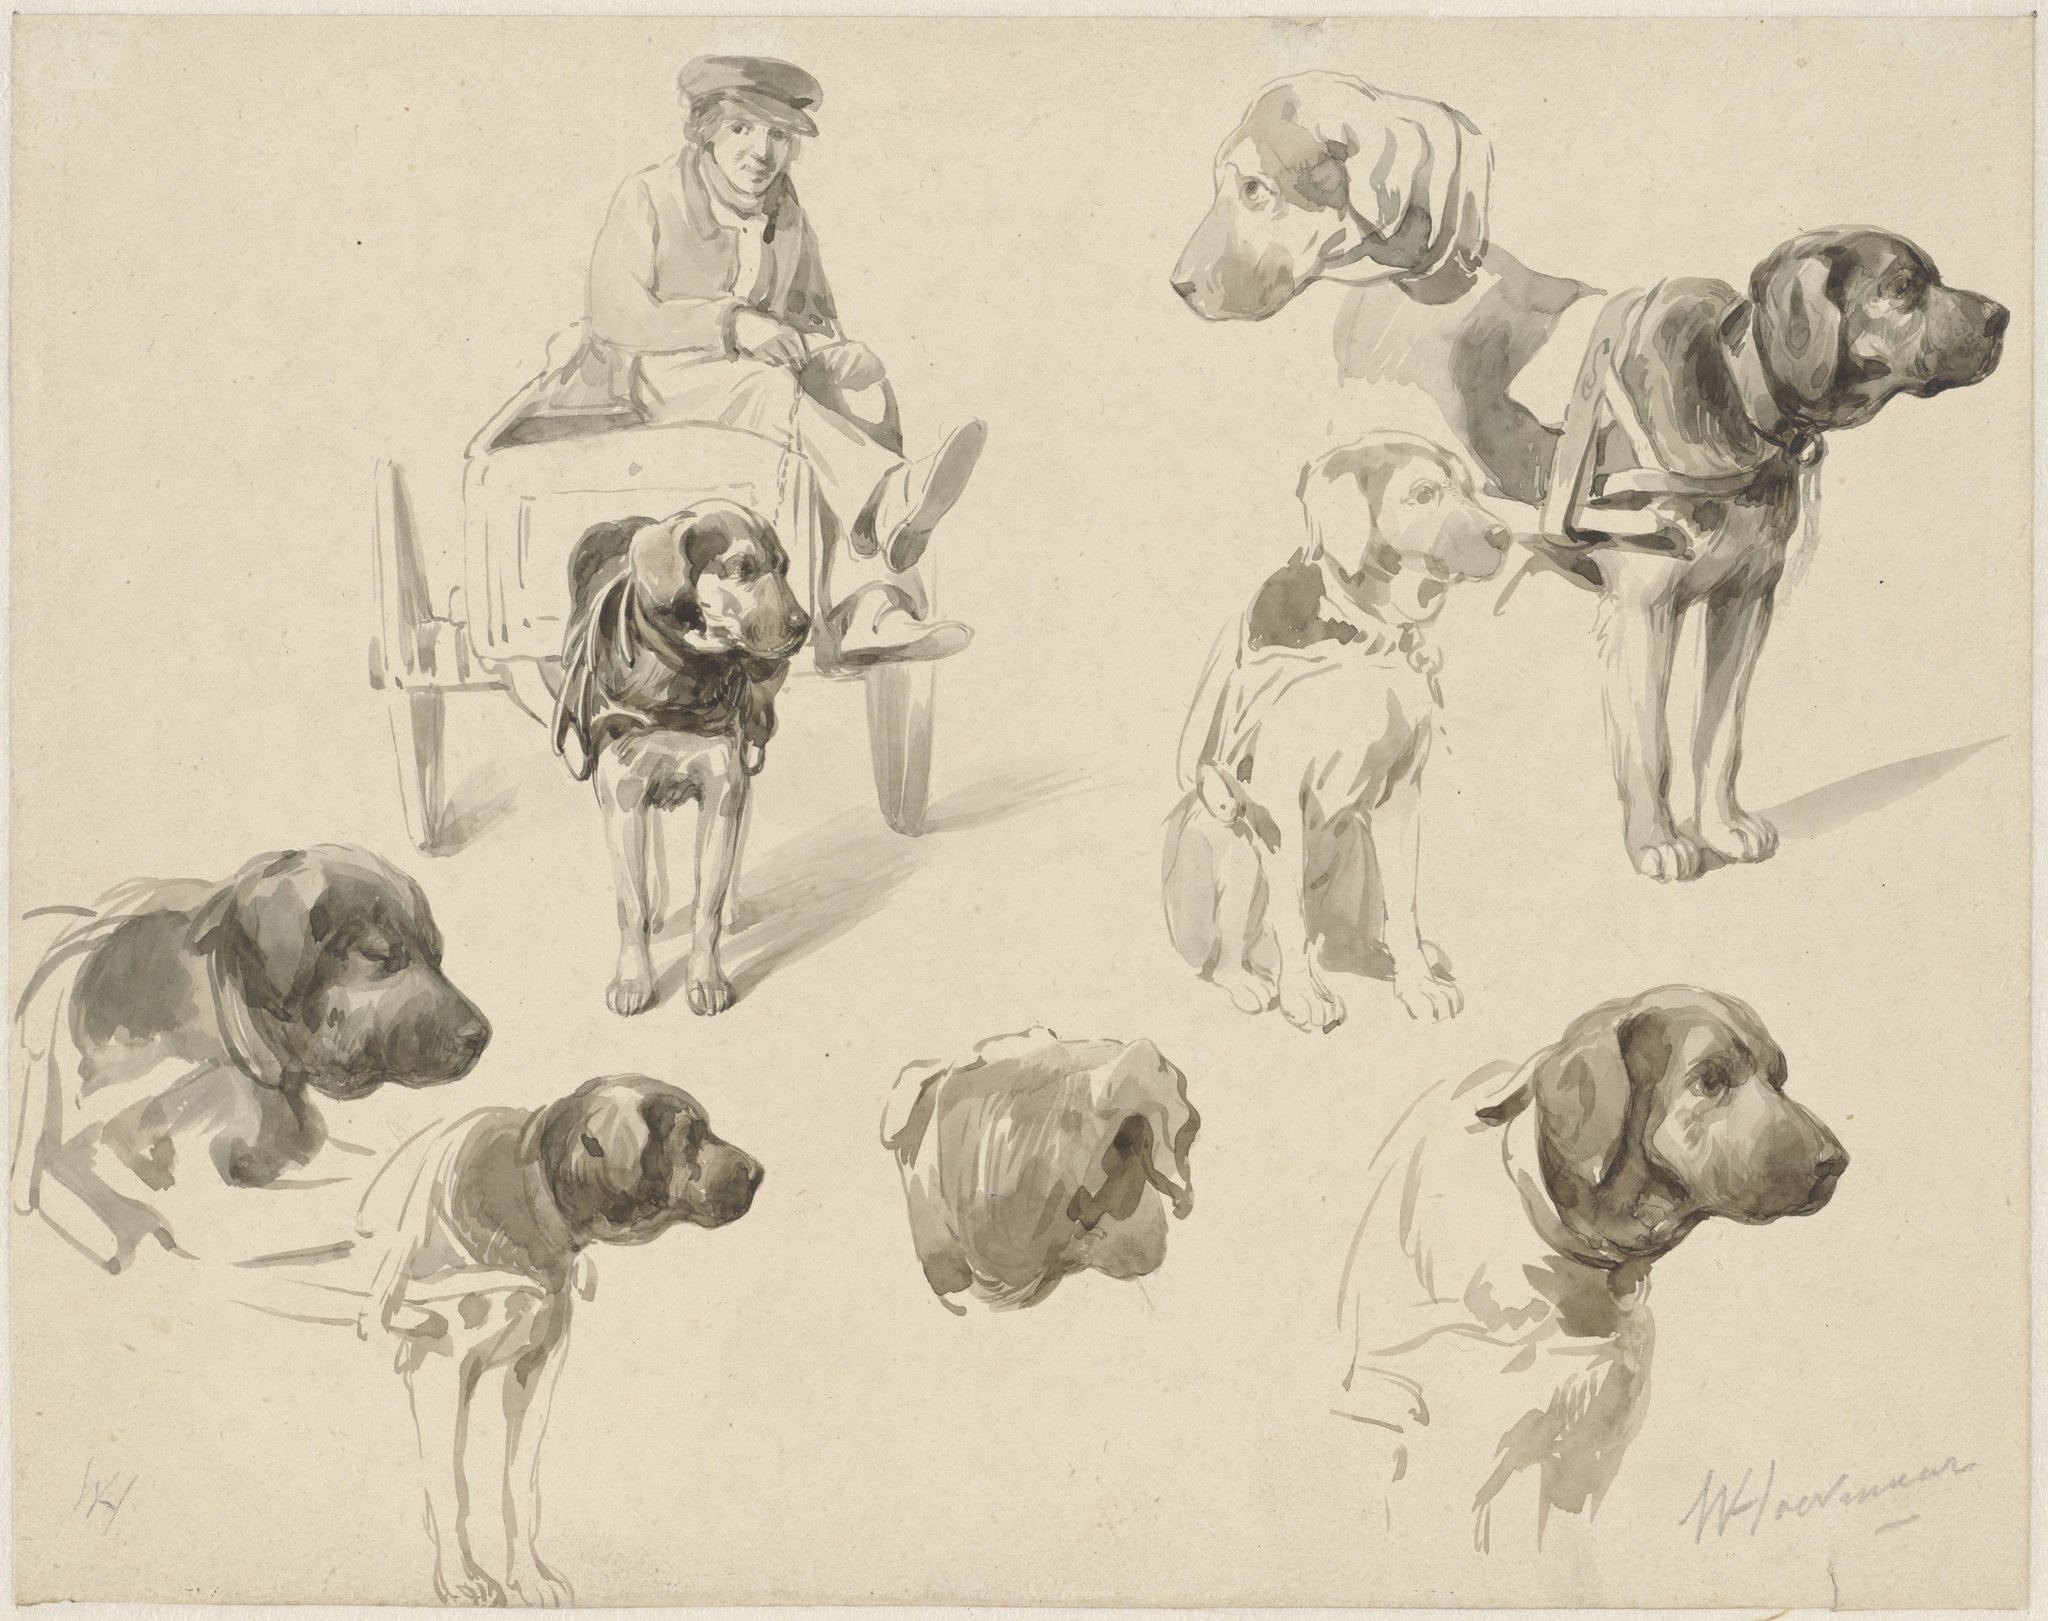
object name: drawing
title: Studies van een hondenkar en een hond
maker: willem pieter hoevenaar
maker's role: draughtsman, painter, print maker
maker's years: 1808-1863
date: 1818-1863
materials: paper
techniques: brush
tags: two-wheeled vehicle drawn by one animal, dog